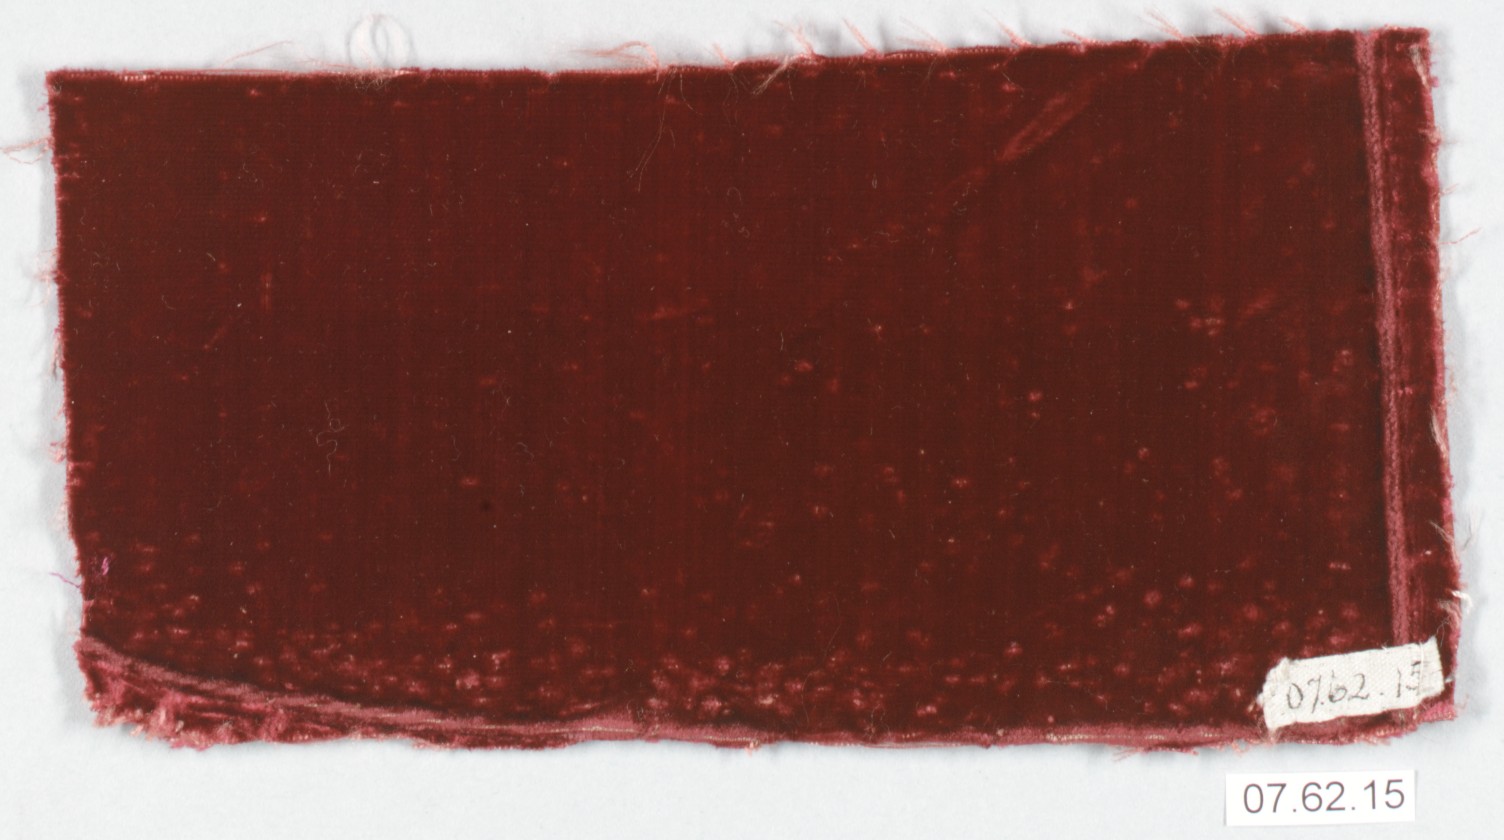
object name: piece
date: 1501-1600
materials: silk